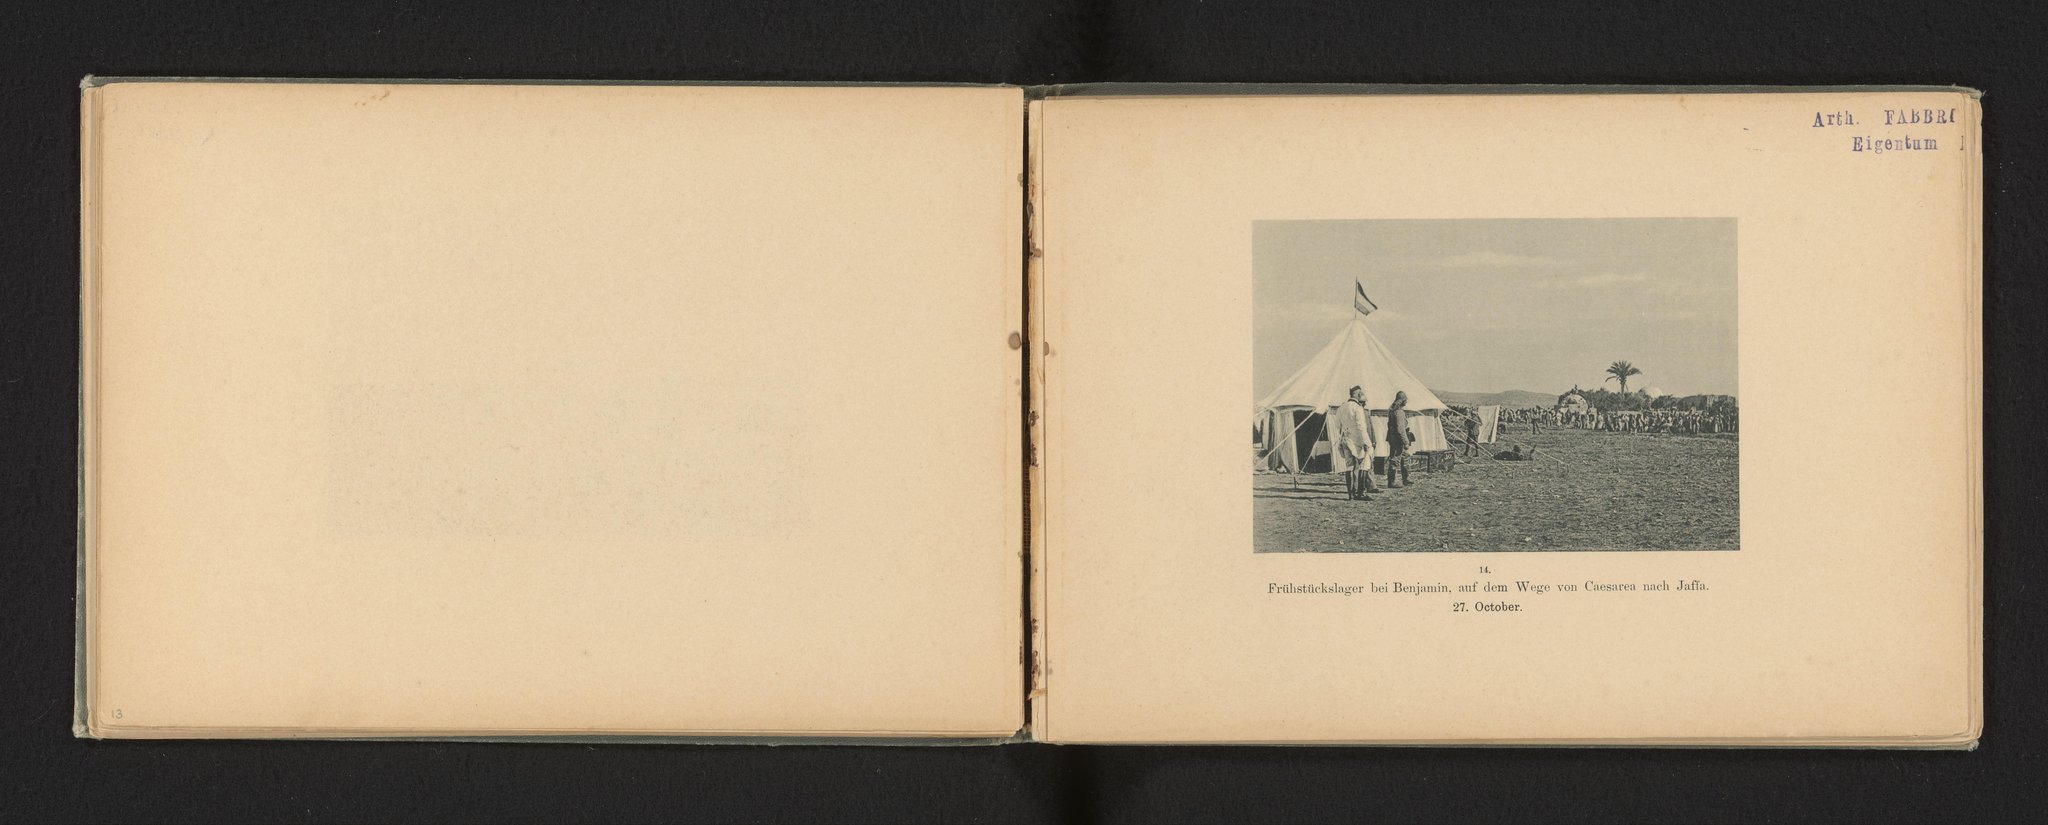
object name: photomechanical print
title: Frühstückslager bei Benjamin, auf dem Wege von Caesarea nach Jaffa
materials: paper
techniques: photograph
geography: israel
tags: wilhelm ii (keizer van duitsland), (traveller) resting in the open air (+ four persons or more ~ traffic and transport)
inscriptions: collector's mark: ‘Arth. FABBR[I]/ Eigentum’, number: ‘14.’